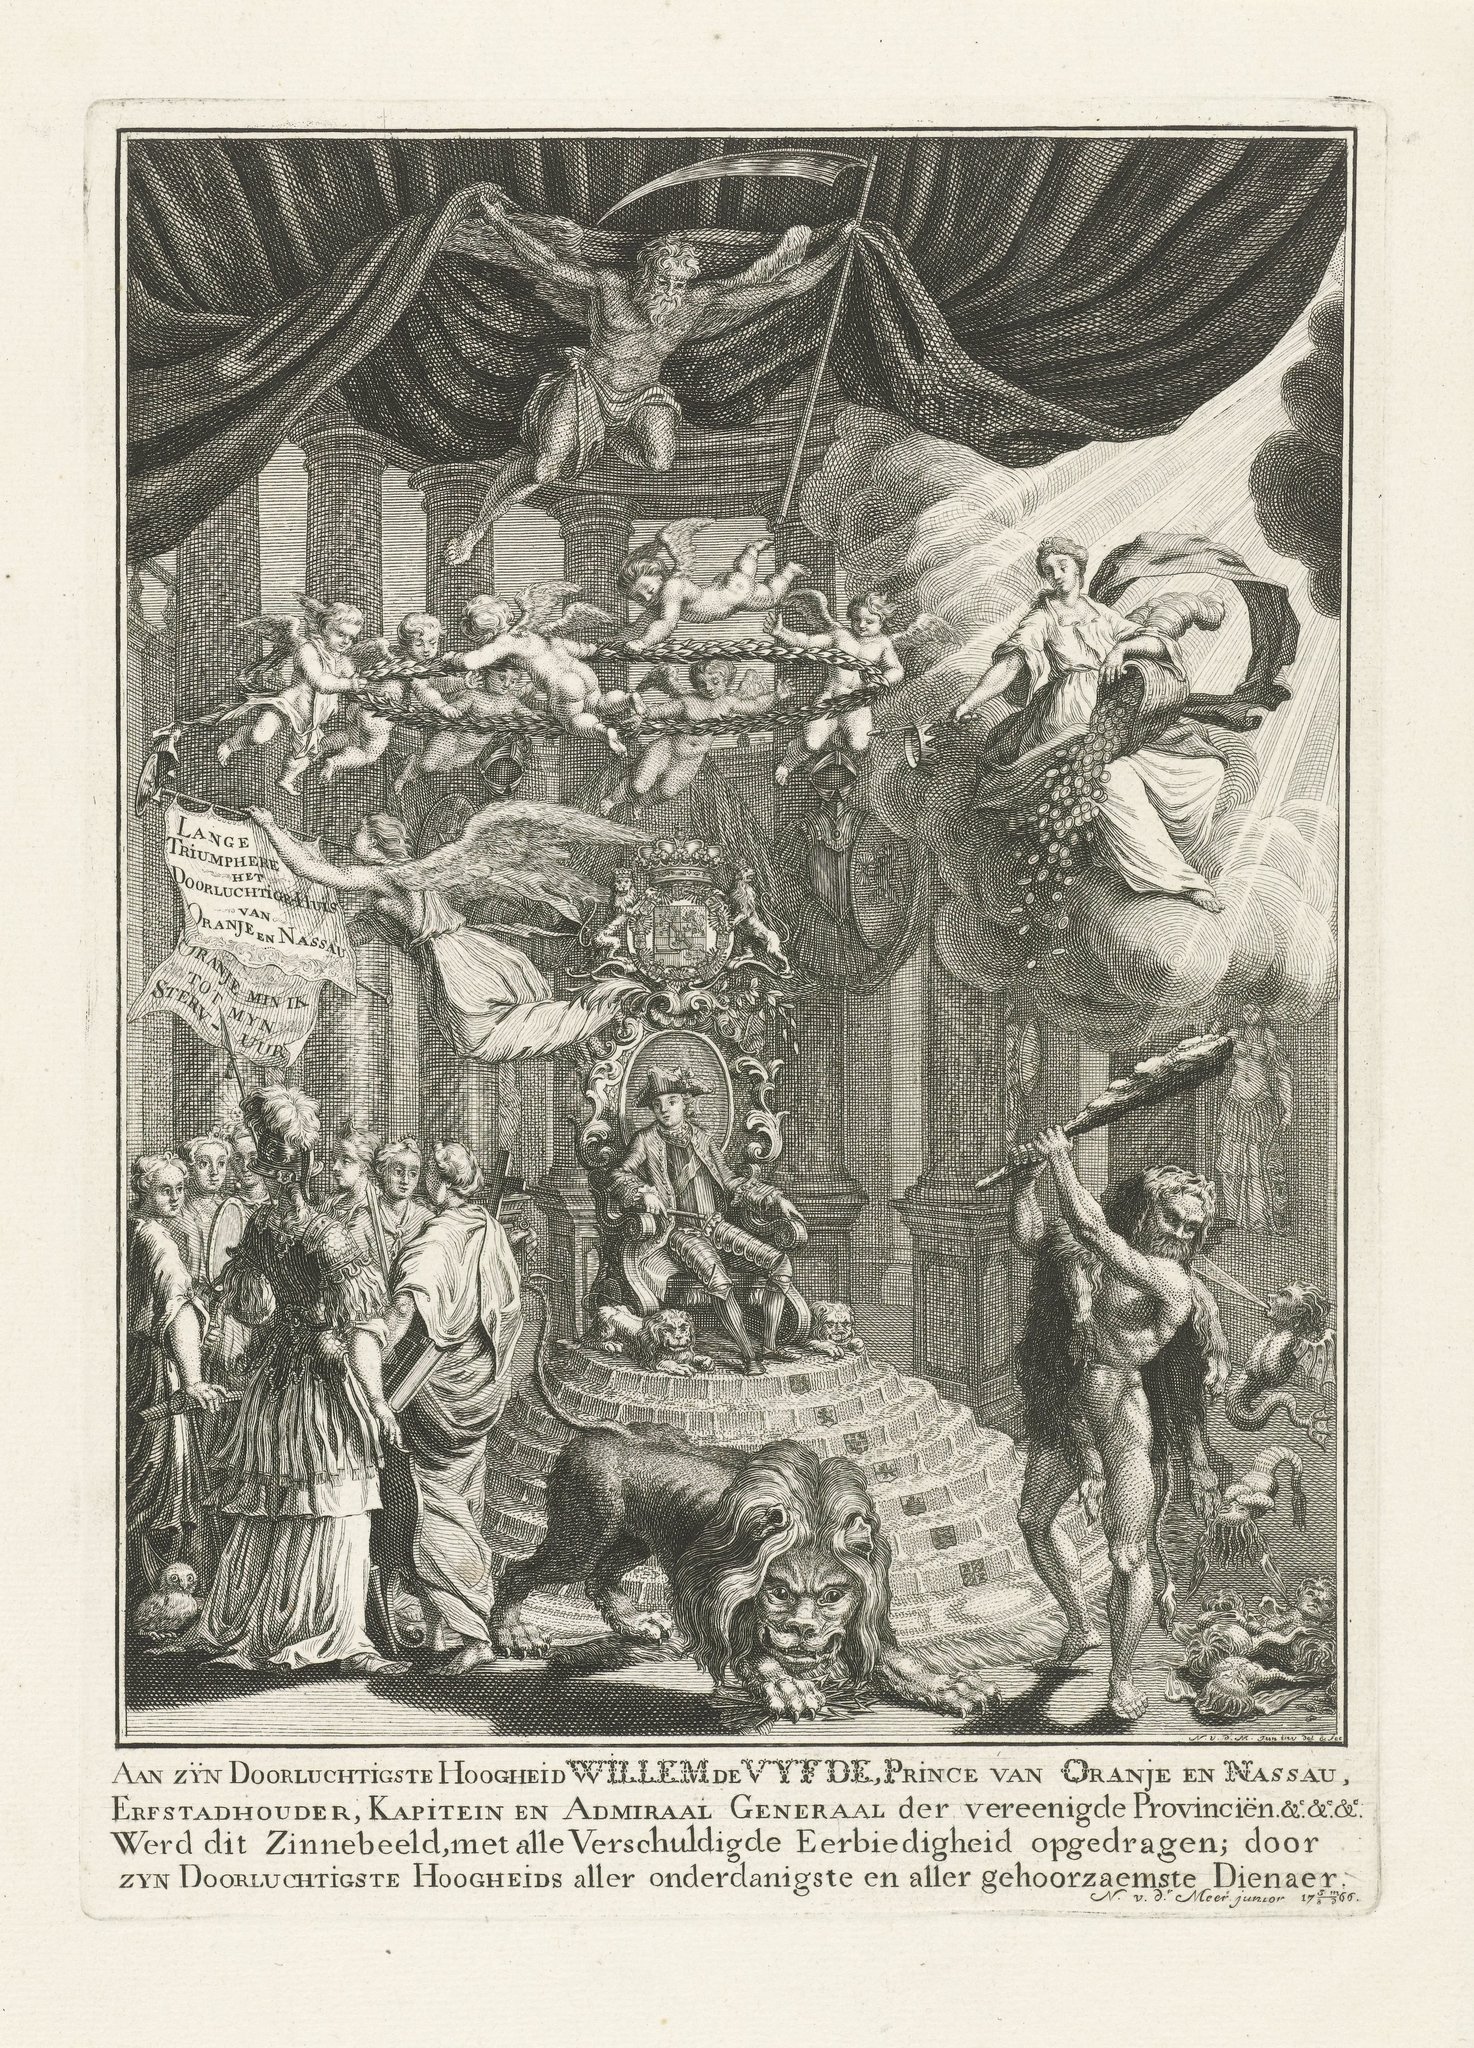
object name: print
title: Allegorie op de installatie van Willem V als erfstadhouder, 1766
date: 1766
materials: paper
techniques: engraving, etching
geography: leiden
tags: the hague, william v (prince of orange), (story of) hercules (heracles), 'sapientia' and the seven virtues, i.e. the three theological and the four cardinal virtues, beasts of prey, predatory animals: lion, father time, man with wings and scythe, abundantia (abundance) as roman personification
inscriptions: collector's mark: Lugt 2228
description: Allegorie op de installatie van prins Willem V als erfstadhouder op achttienjarige leeftijd op 8 maart 1766. Centraal de prins zittend op zijn troon, rechts verslaat Hercules de serpenten, links de verzamelde zeven deugden. Boven de troon vliegt de Faam en openbaart Vader Tijd zeven cherubijnen met een grote lauwerkrans, rechts schenkt de Overvloed rijkdommen. Op de voorgrond de Nederlandse Leeuw. In het onderschrift in 4 regels de opdracht aan de stadhouder.